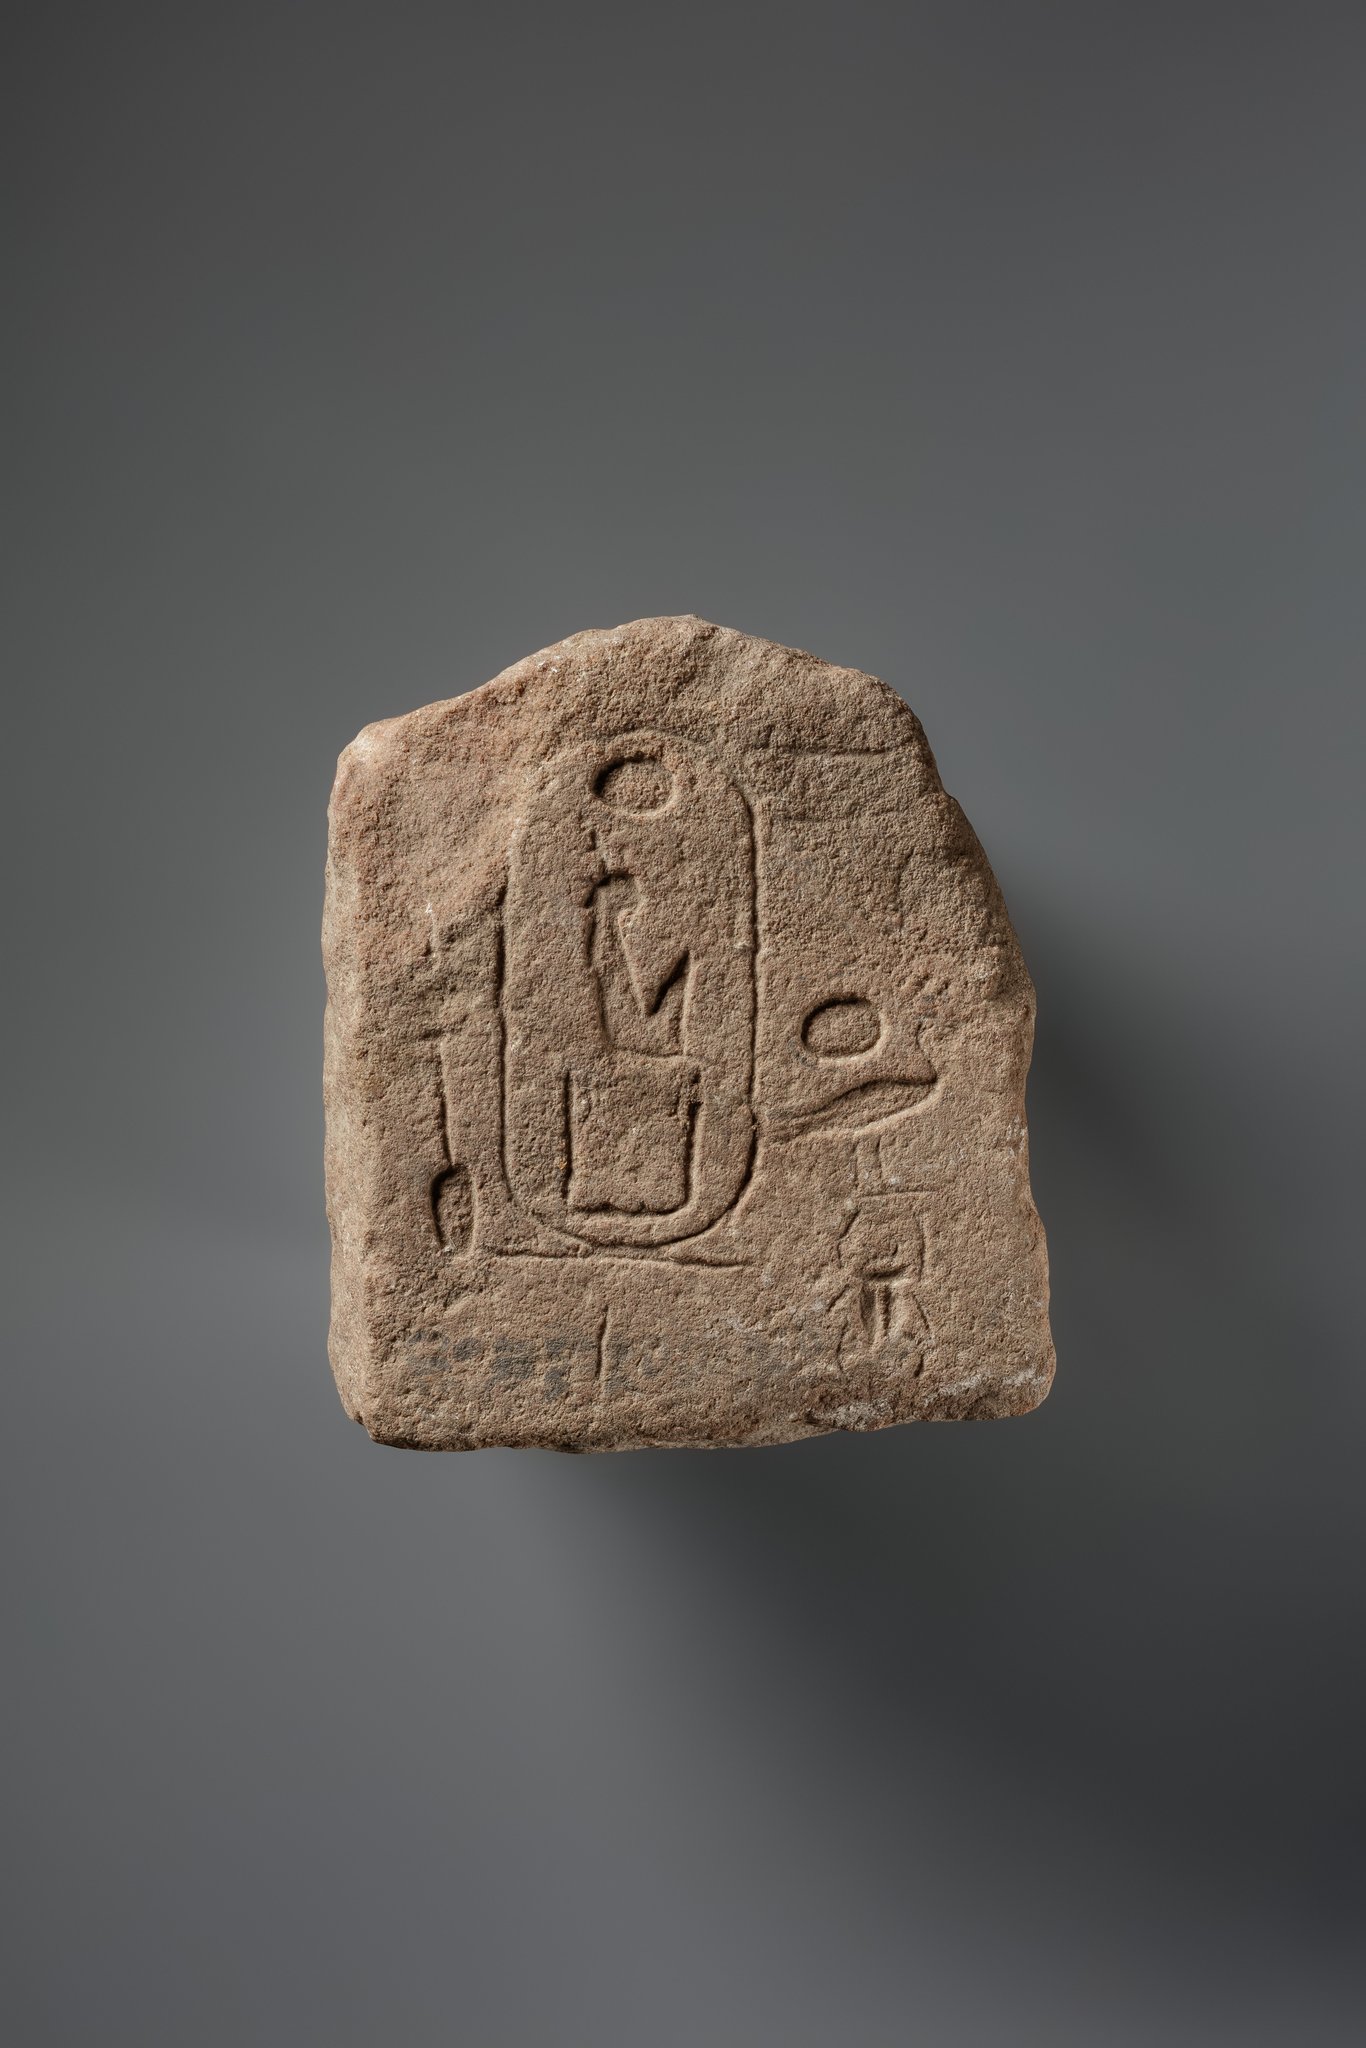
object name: inscribed stone, hatshepsut, maatkare, hieratic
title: Inscribed Stone from Hatshepsut's Valley Temple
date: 1479-1458 BCE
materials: ink, quartzite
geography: egypt